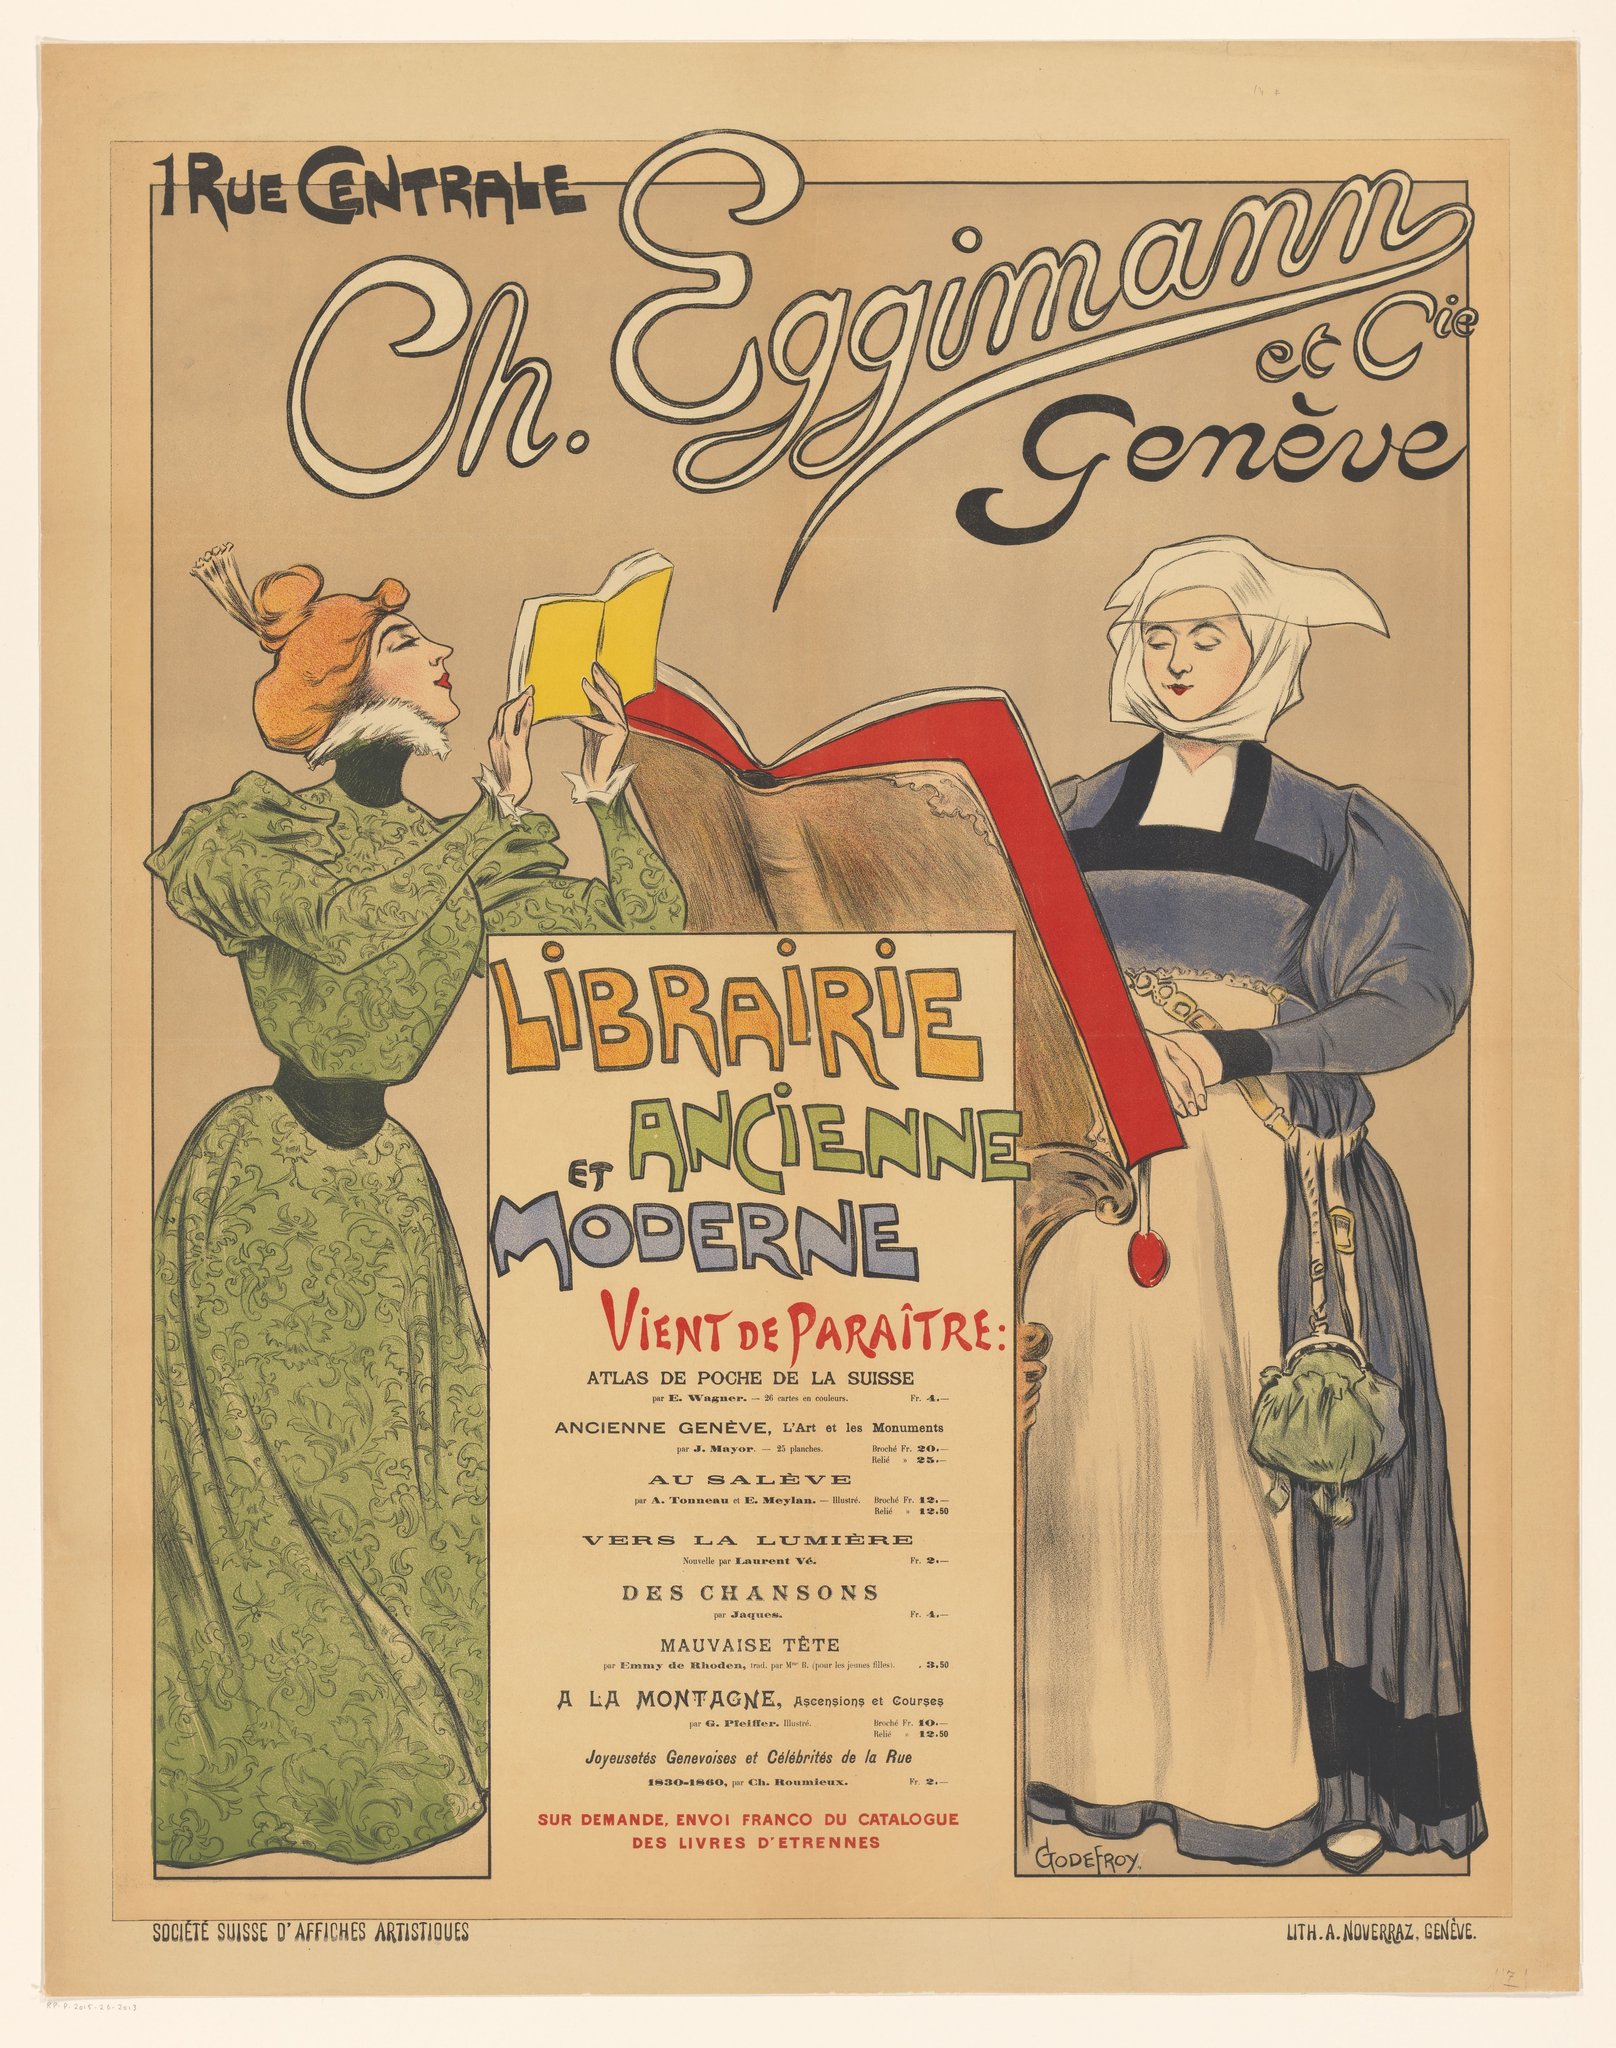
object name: print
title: Affiche van uitgever Ch. Eggimann et Cie te Genève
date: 1897-1900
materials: paper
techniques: lithograph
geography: geneva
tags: purse, money-bag, book, lectern ~ reading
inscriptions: collector's mark: Lugt 2228, collector's mark: Lugt 4779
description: Rechts een vrouw in traditionele kleding met een geldbuidel aan haar riem, lezend uit een boek dat voor haar op een lessenaar staat. Links een vrouw in modieuze kleding met een boek in haar hand. In het midden een overzicht van recent verschenen titels.